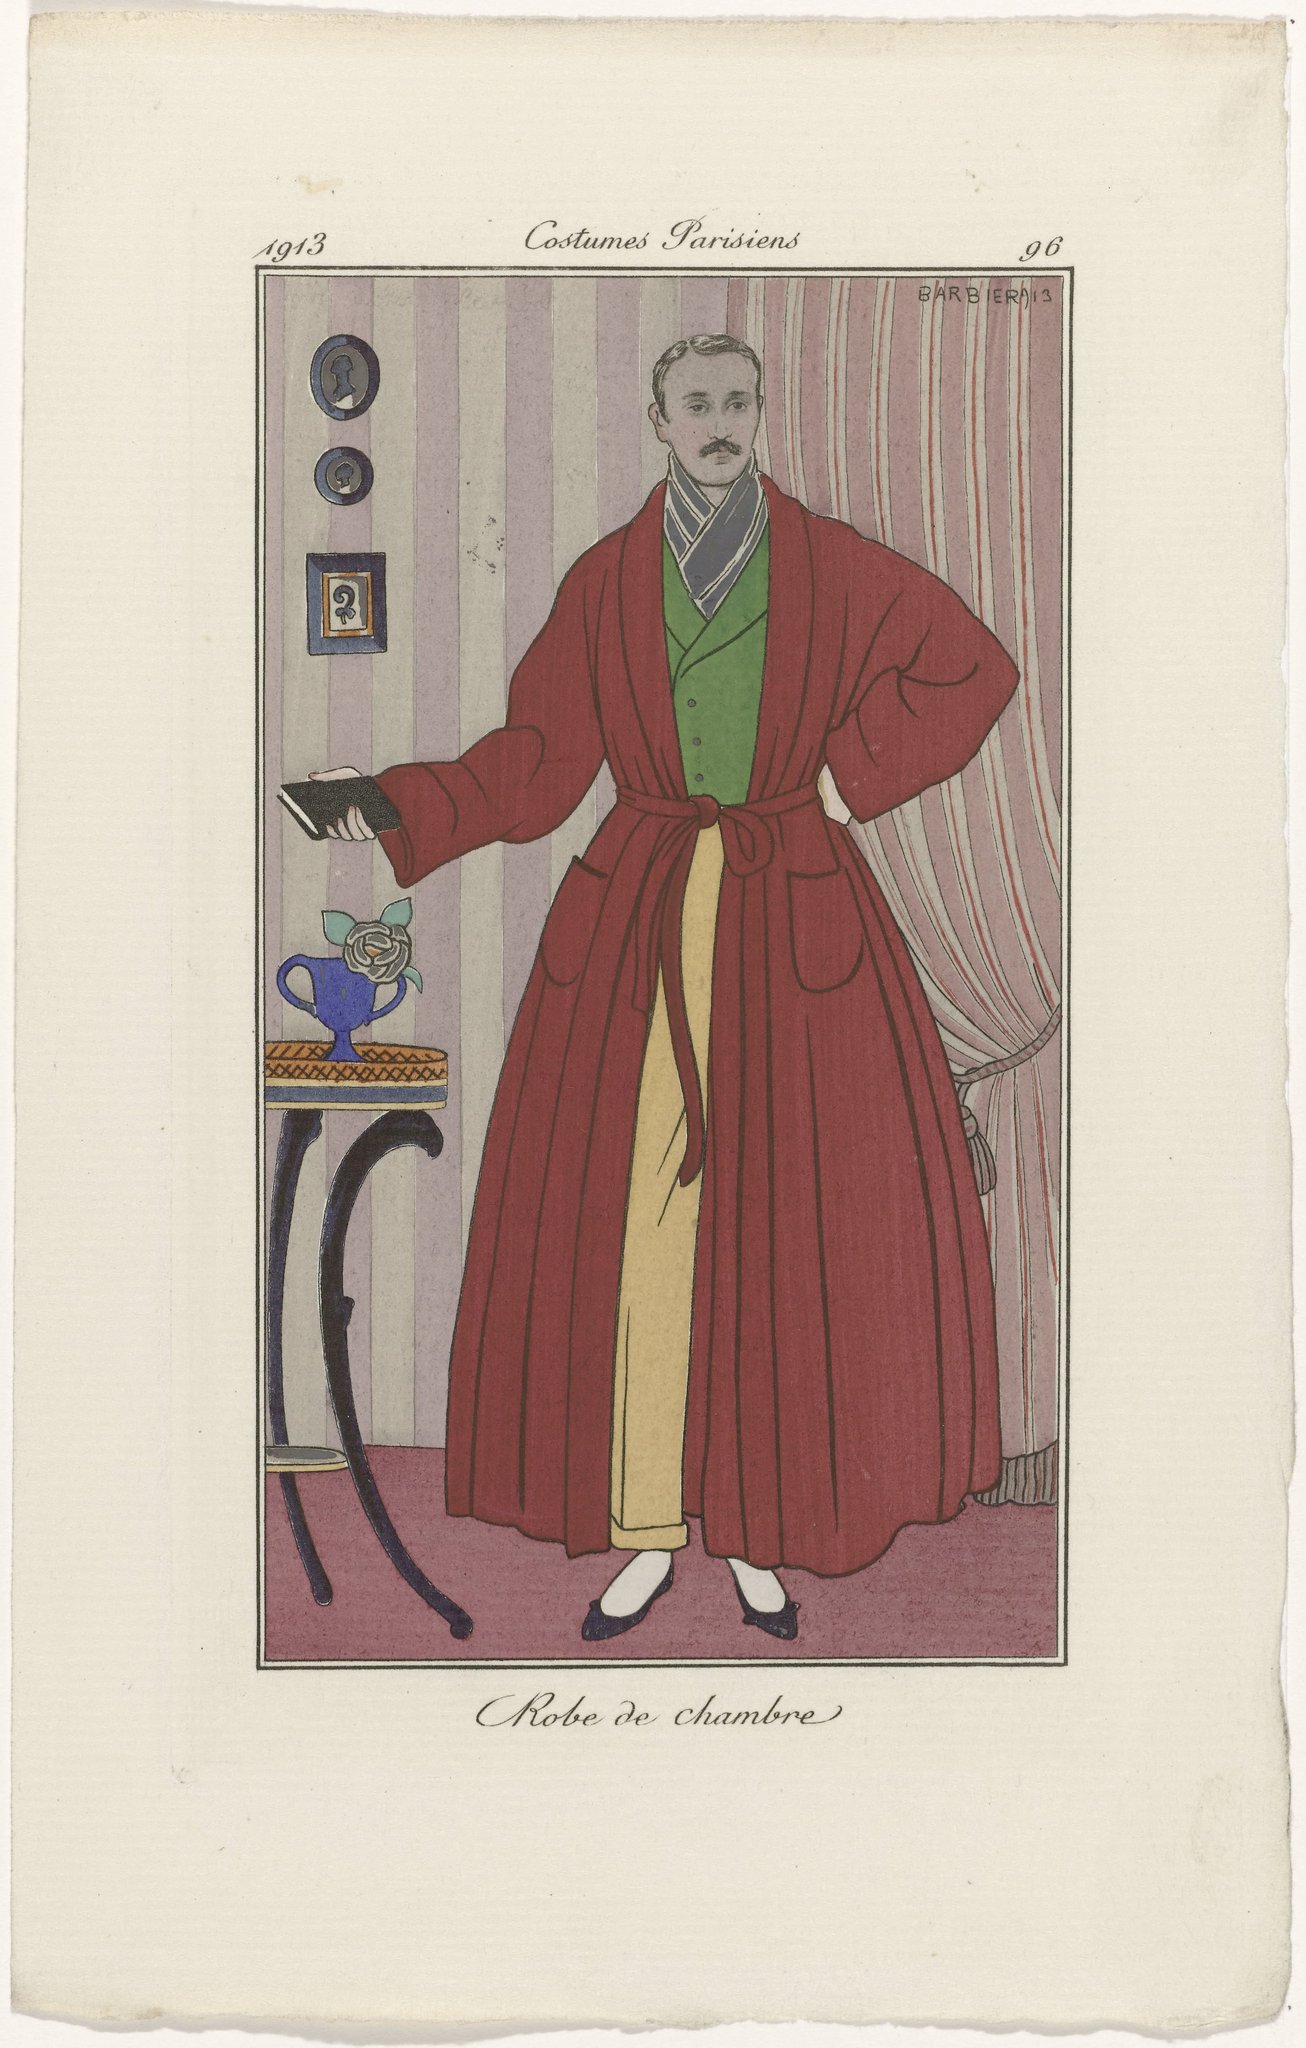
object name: fashion print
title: Journal des Dames et des Modes: Fashion News Journal des Dames et des Modes: the Fashion Illustrators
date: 1913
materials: paper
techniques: engraving, hand coloring, pochoir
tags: clothing for the upper part of the body (vest) (+ men's clothes), trousers, breeches, etc. (pantalon) (+ men's clothes), housecoat (+ men's clothes), fashion plates, book, clothes, costume (+ men's clothes)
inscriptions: title: ‘Costumes Parisiens’, caption: ‘Robe de chambre.’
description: The Journal des Dames was inspired by the eponymous fashion magazine from the previous century and, like the earlier publication, referred to its illustrations as Costumes Parisiens. These Costumes Parisiens (184 illustrations in total) were drawn in a new, flat, decorative manner by George Barbier, Jan van Brock, Victor Lhuer and other Parisian artists, each with a signature style. Every issue came with two or three separate plates. These showed a wide variety of fashionable apparel, from elegant evening attire to outdoor outfits. A brief caption provides the name of the garment and the material from which it was made, but never the name of a fashion house.